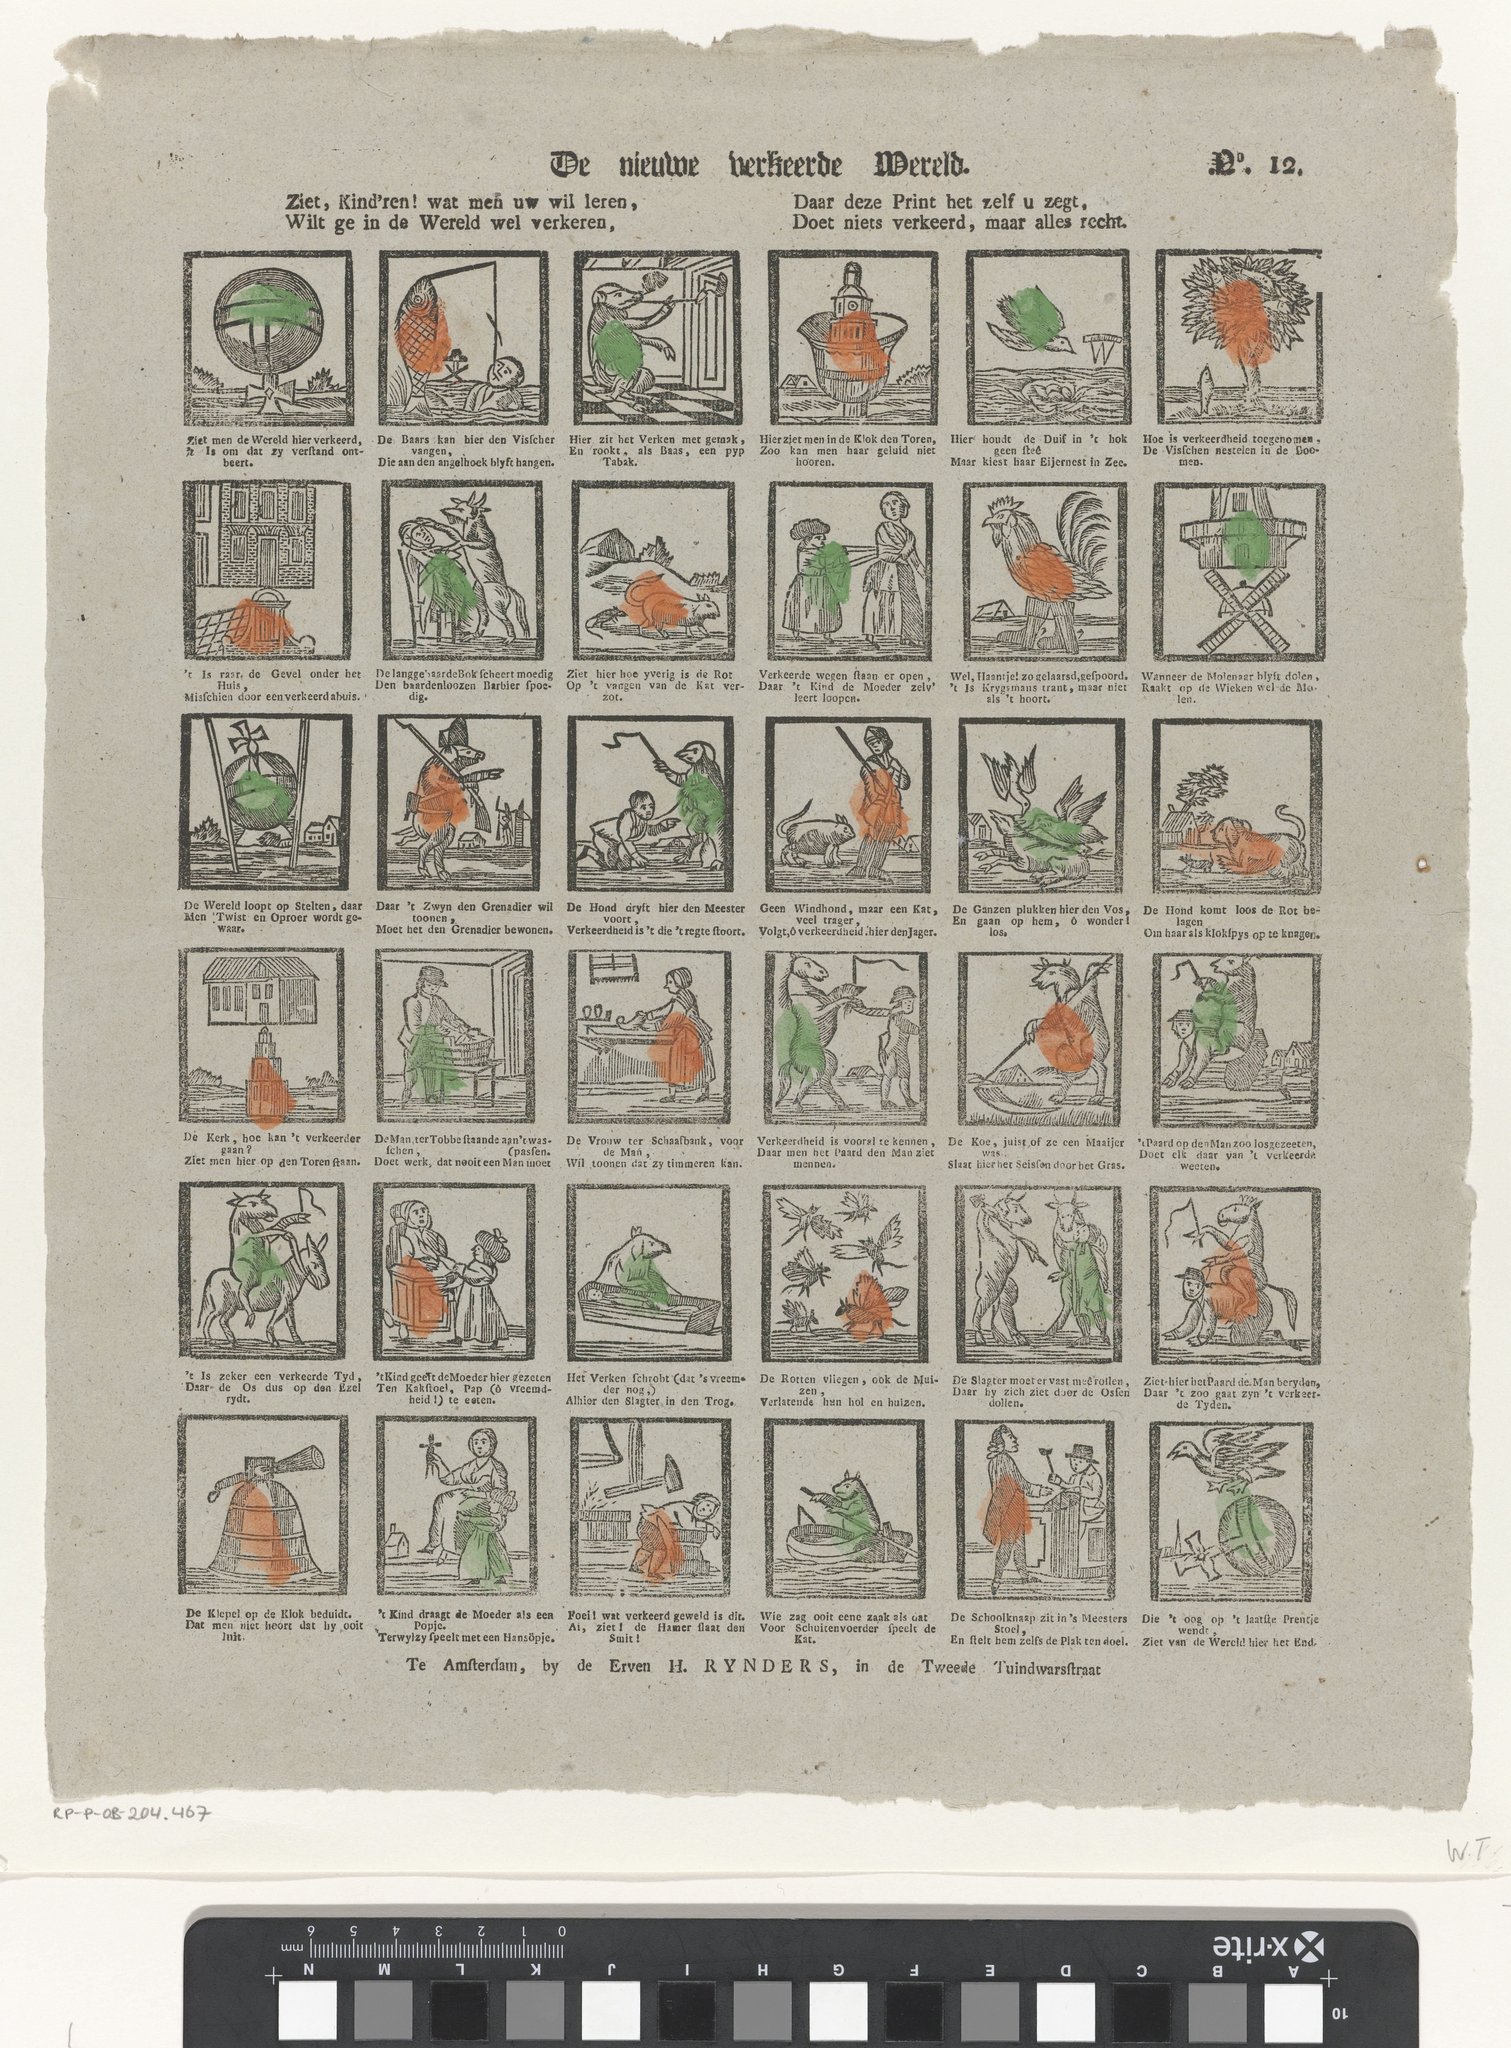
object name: print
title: De nieuwe verkeerde wereld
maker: Anonymous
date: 1831-1854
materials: paper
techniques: colour, letterpress printing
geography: amsterdam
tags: 'mundus inversus', the reversed world, the topsy-turvy world, 'le monde bestourné', animals acting as human beings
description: Blad met 36 voorstellingen van de verkeerde wereld, waar onder andere dieren zich als mensen gedragen. Onder elke afbeelding een onderschrift. Genummerd rechtsboven: No. 12.